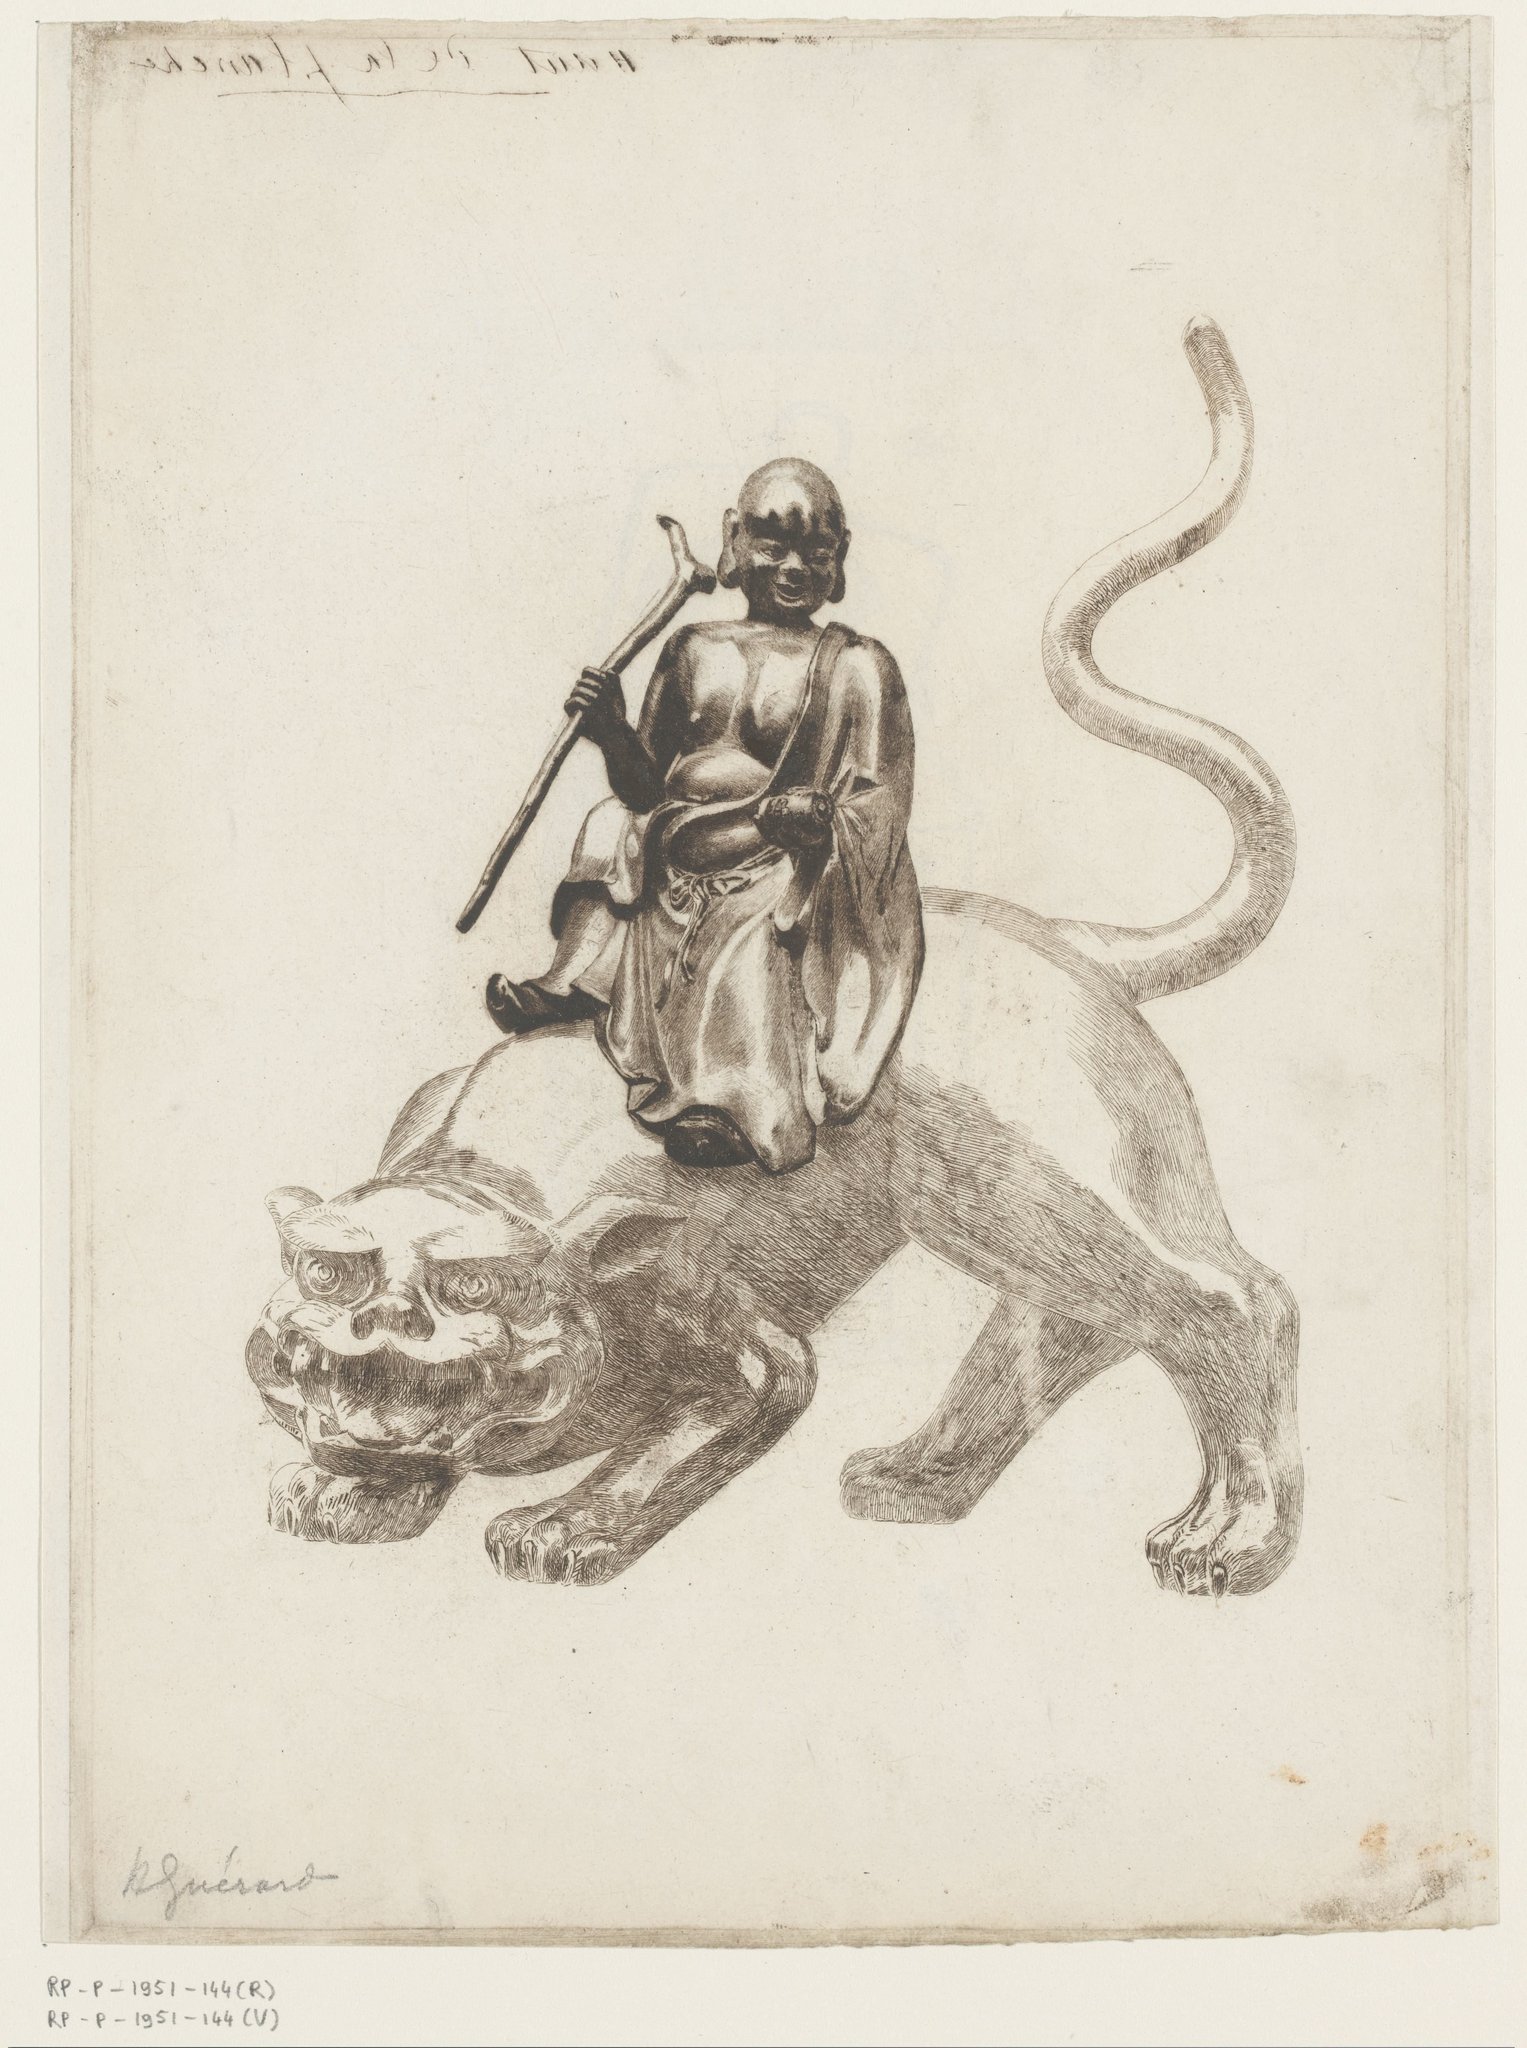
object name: print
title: Bronzen beeld van een Japanse godheid (Sennin) op een leeuw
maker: henri charles guérard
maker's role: print maker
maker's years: 1846-1897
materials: paper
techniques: etching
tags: non-christian religions (including institutions, customs and antiquities), beasts of prey, predatory animals: lion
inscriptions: collector's mark: Lugt 2228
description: Latere staat gebruikt voor: Gonse, Louis. Art Japonais. Parijs: A. Quantin, 1883, dl. 1, p. 16. Het bronzen beeld bevond zich in de collectie van Henri Cernuschi.